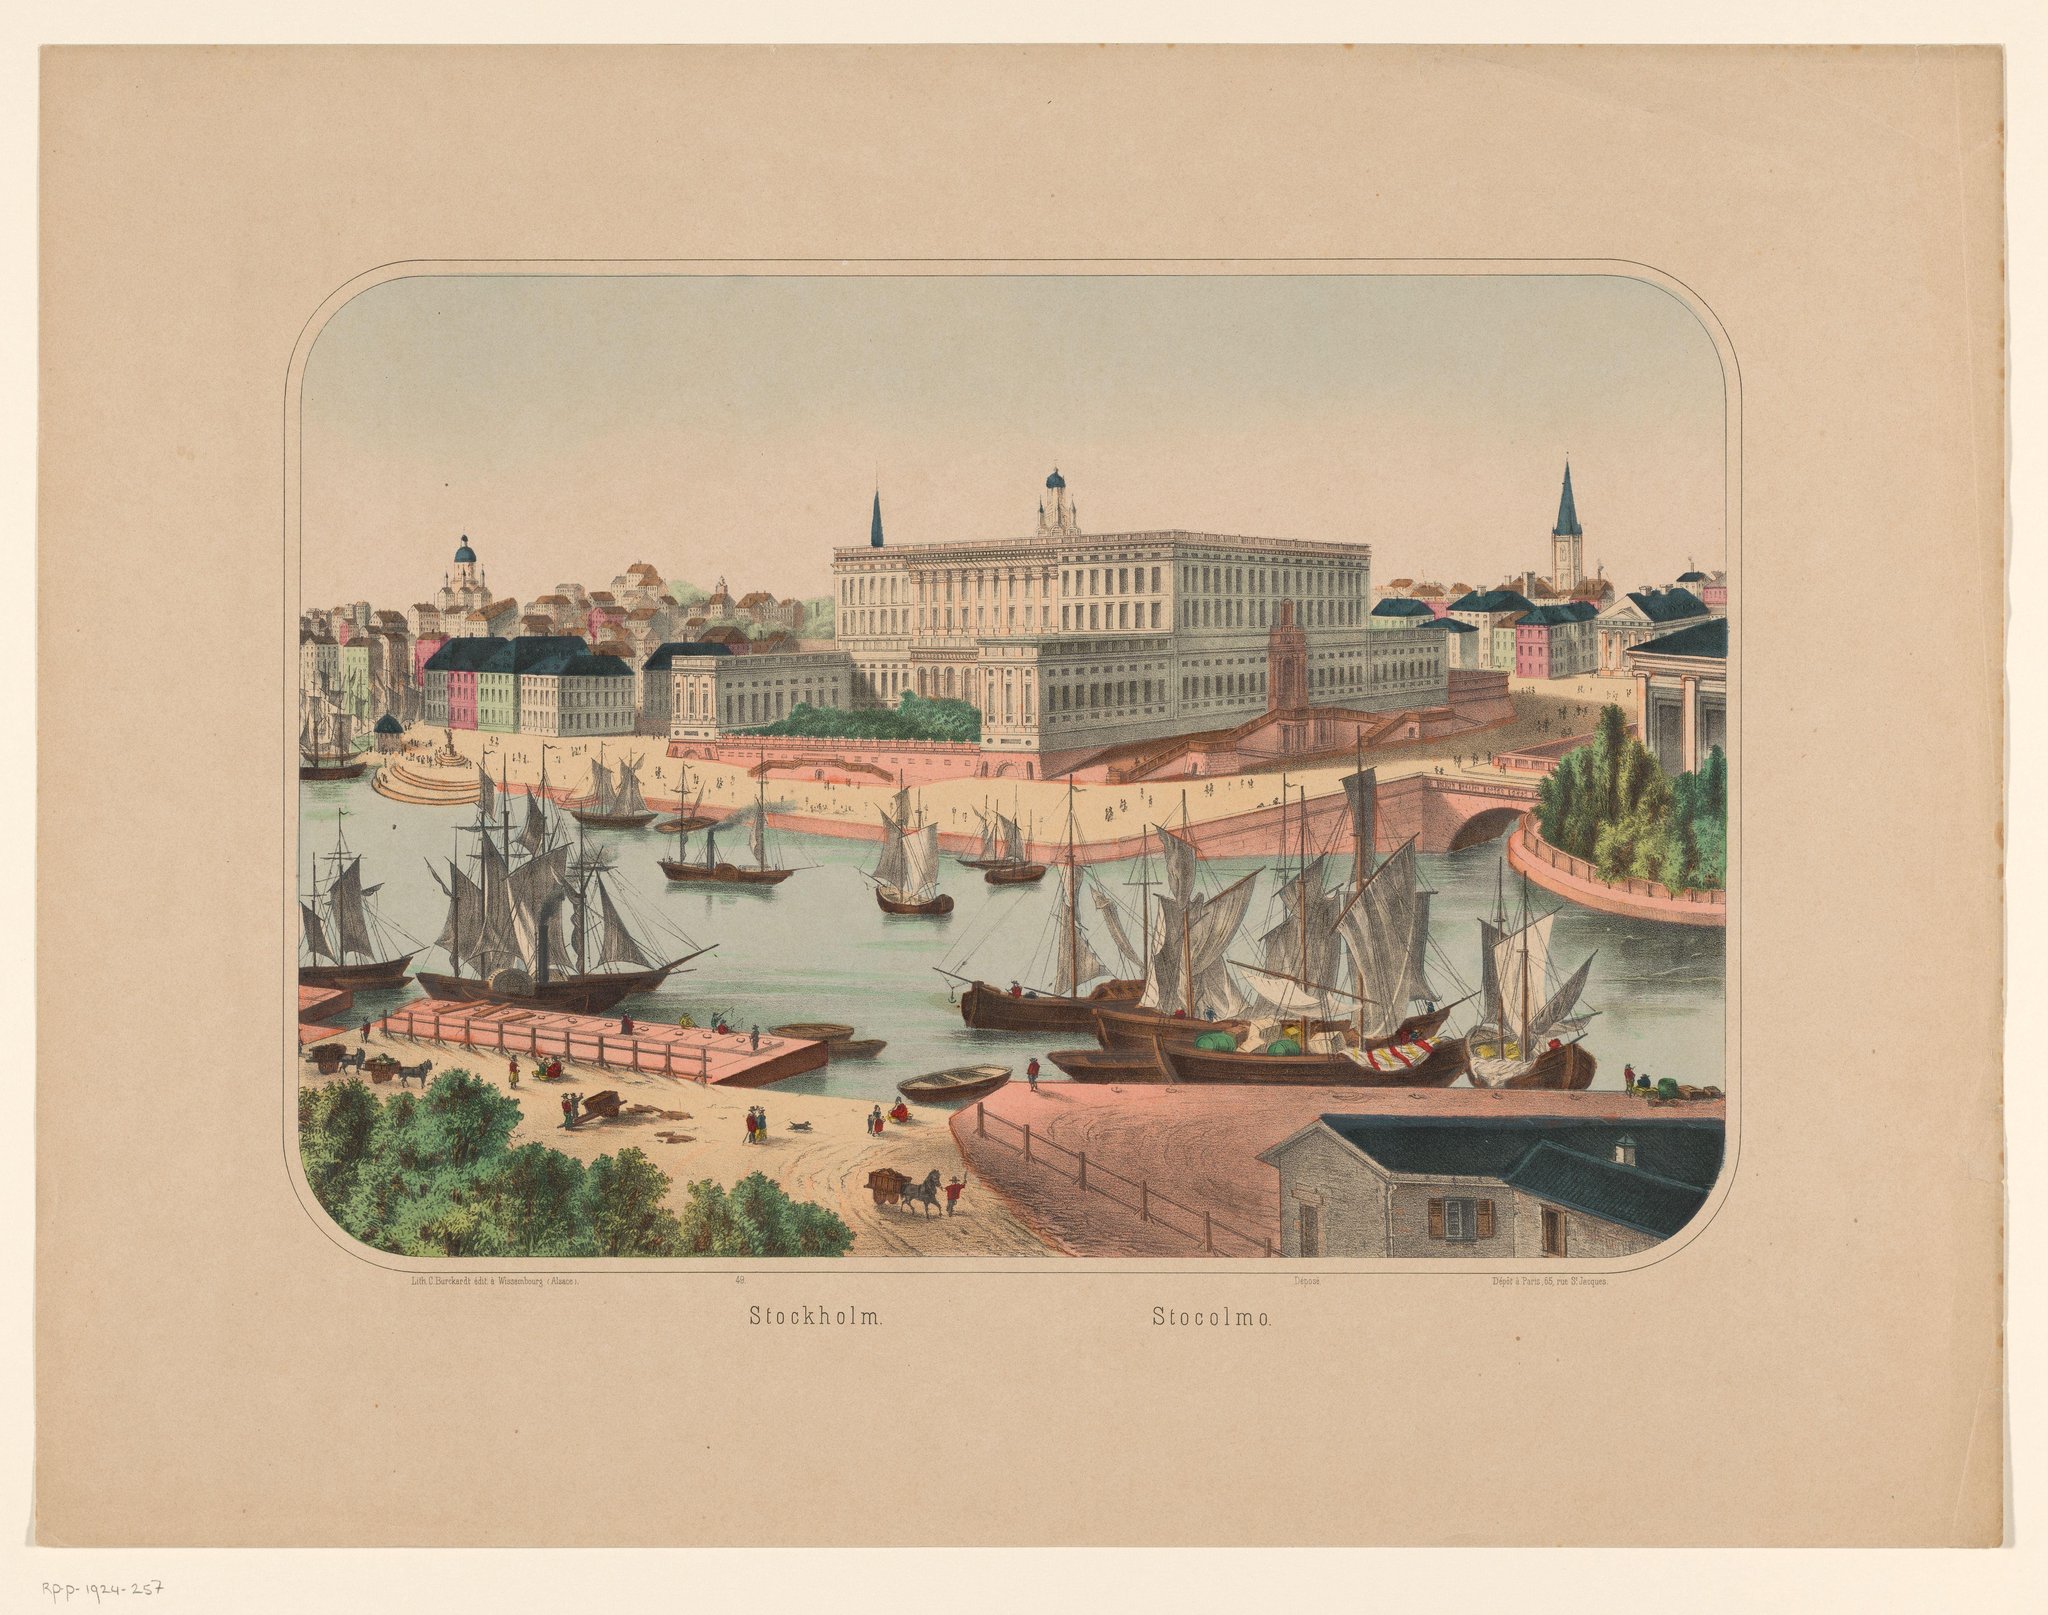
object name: print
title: Gezicht op Stockholm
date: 1870-1889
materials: paper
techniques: lithograph, hand coloring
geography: wissembourg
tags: palace, prospect of city, town panorama, silhouette of city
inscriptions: : ‘Déposé’, collector's mark: Lugt 2233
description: Gezicht op Stockholm, met centraal het Koninklijk Paleis.